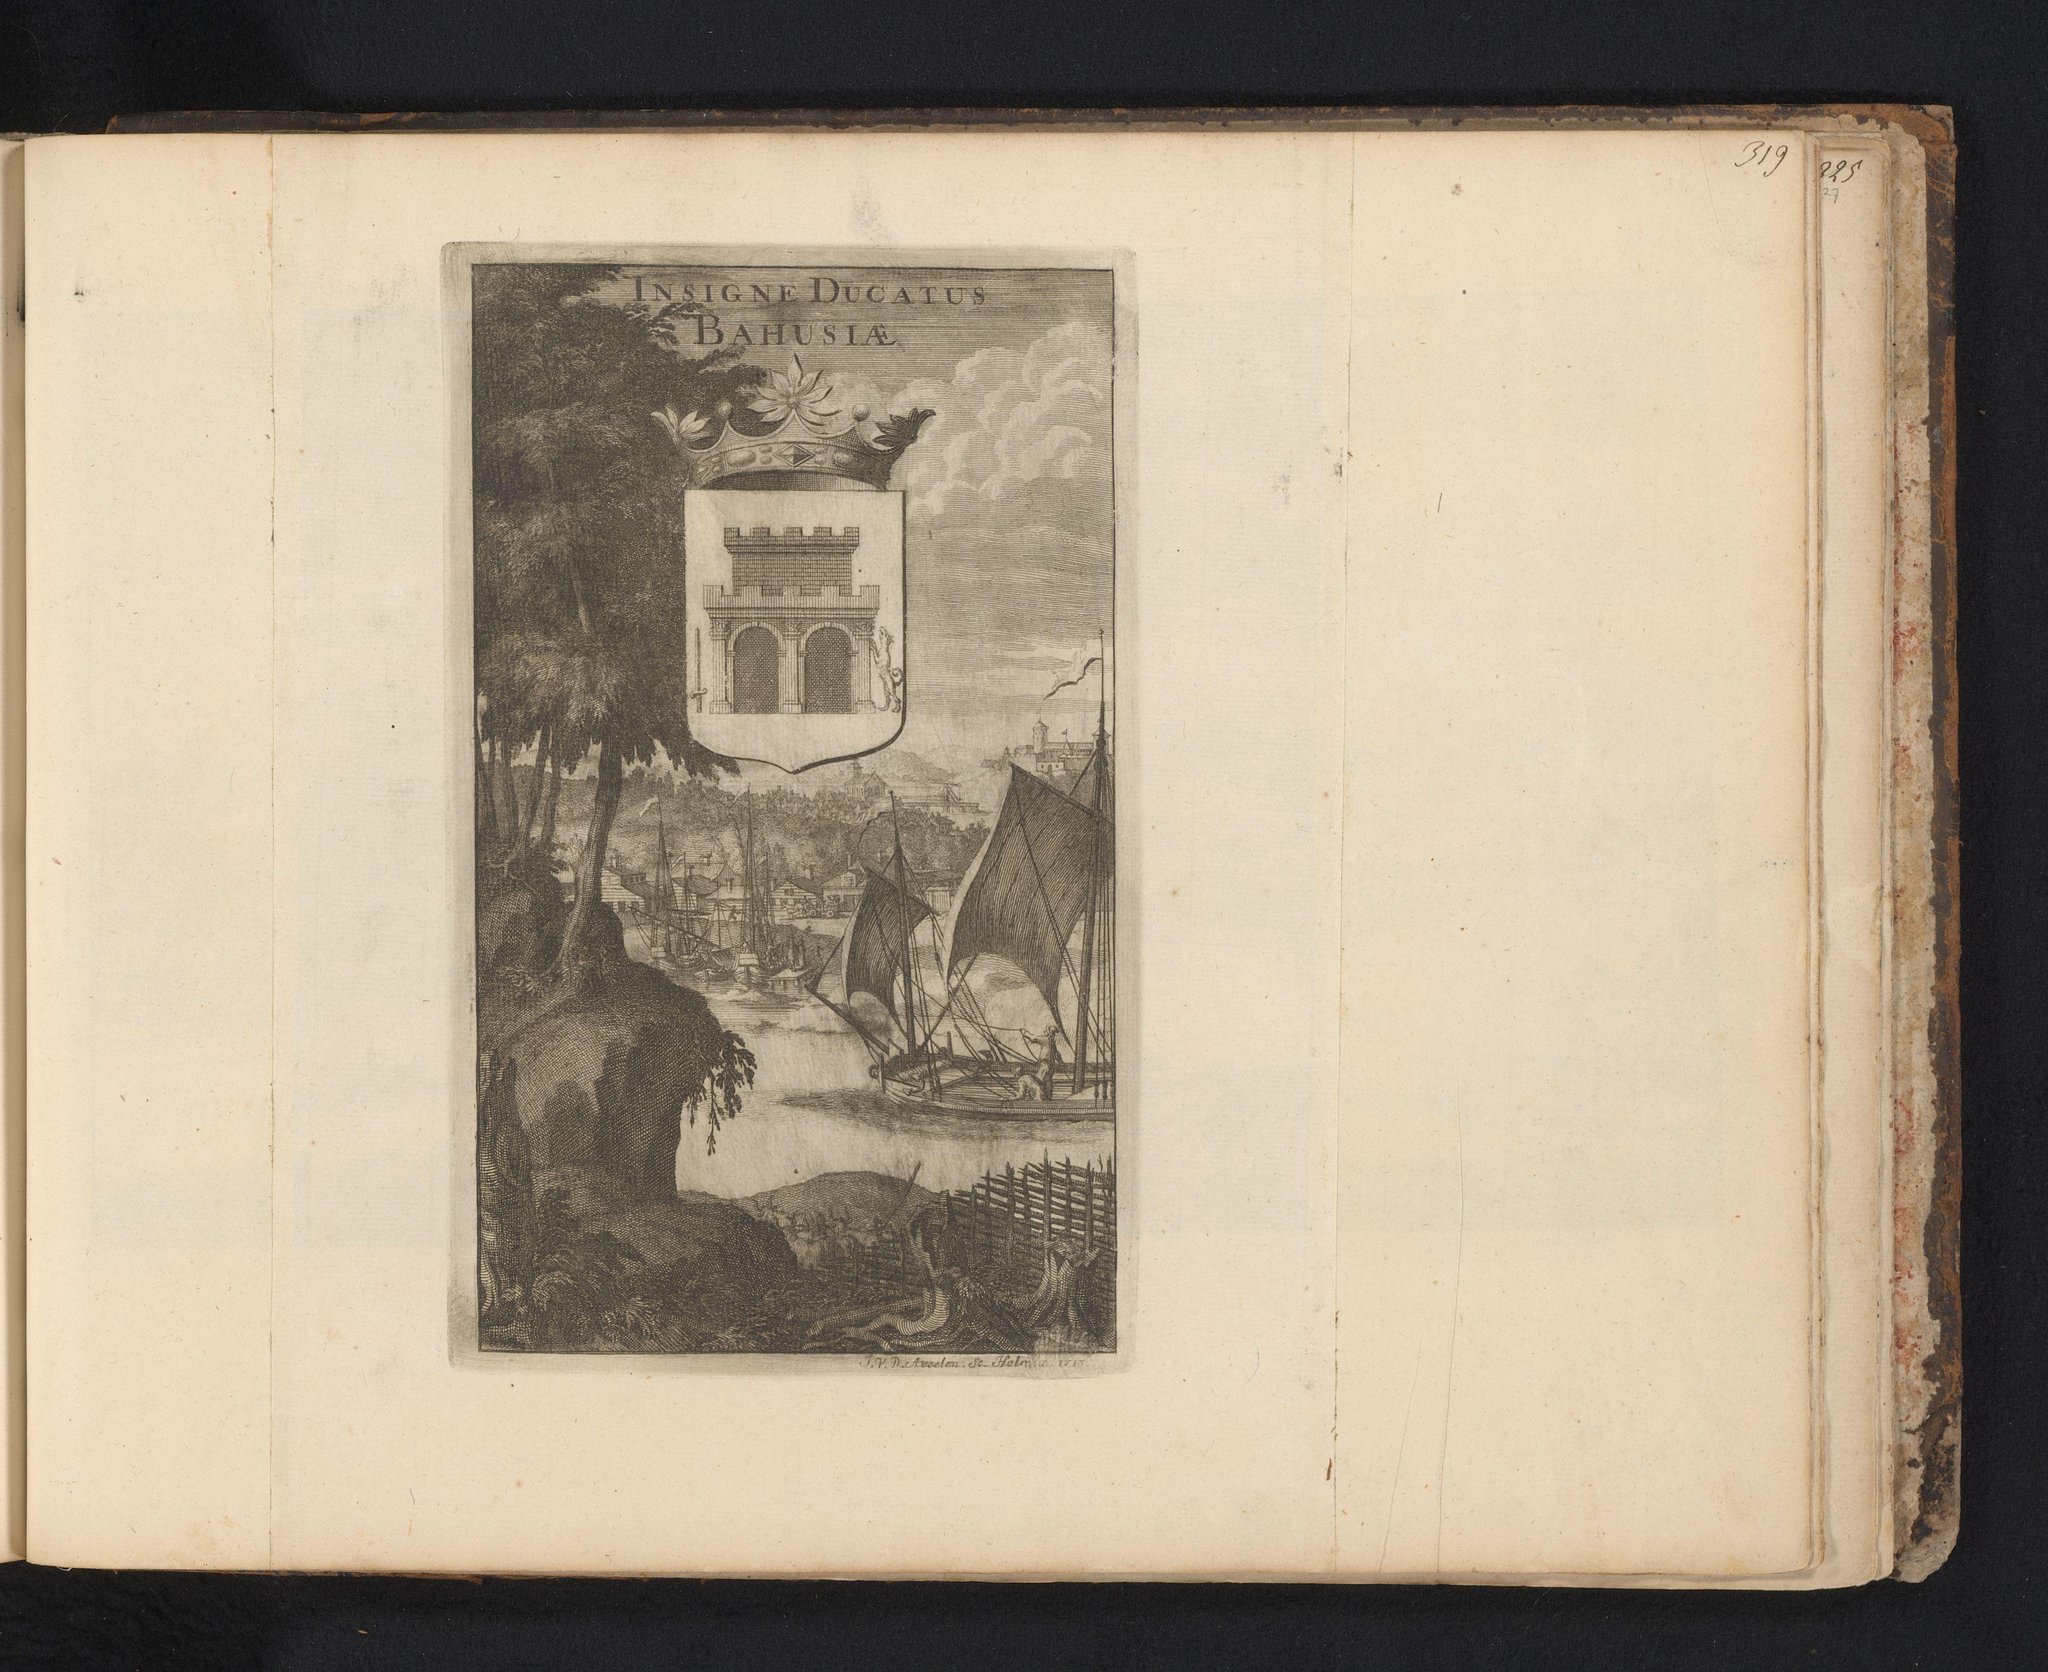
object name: print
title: Suecia Antiqua et Hodierna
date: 1713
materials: paper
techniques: etching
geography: stockholm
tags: harbour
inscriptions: date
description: Kungliga Biblioteket, 'Suecia': http://www.kb.se/samlingarna/Kartor-bilder/Suecia-antiqua/ (geraadpleegd november 2016).